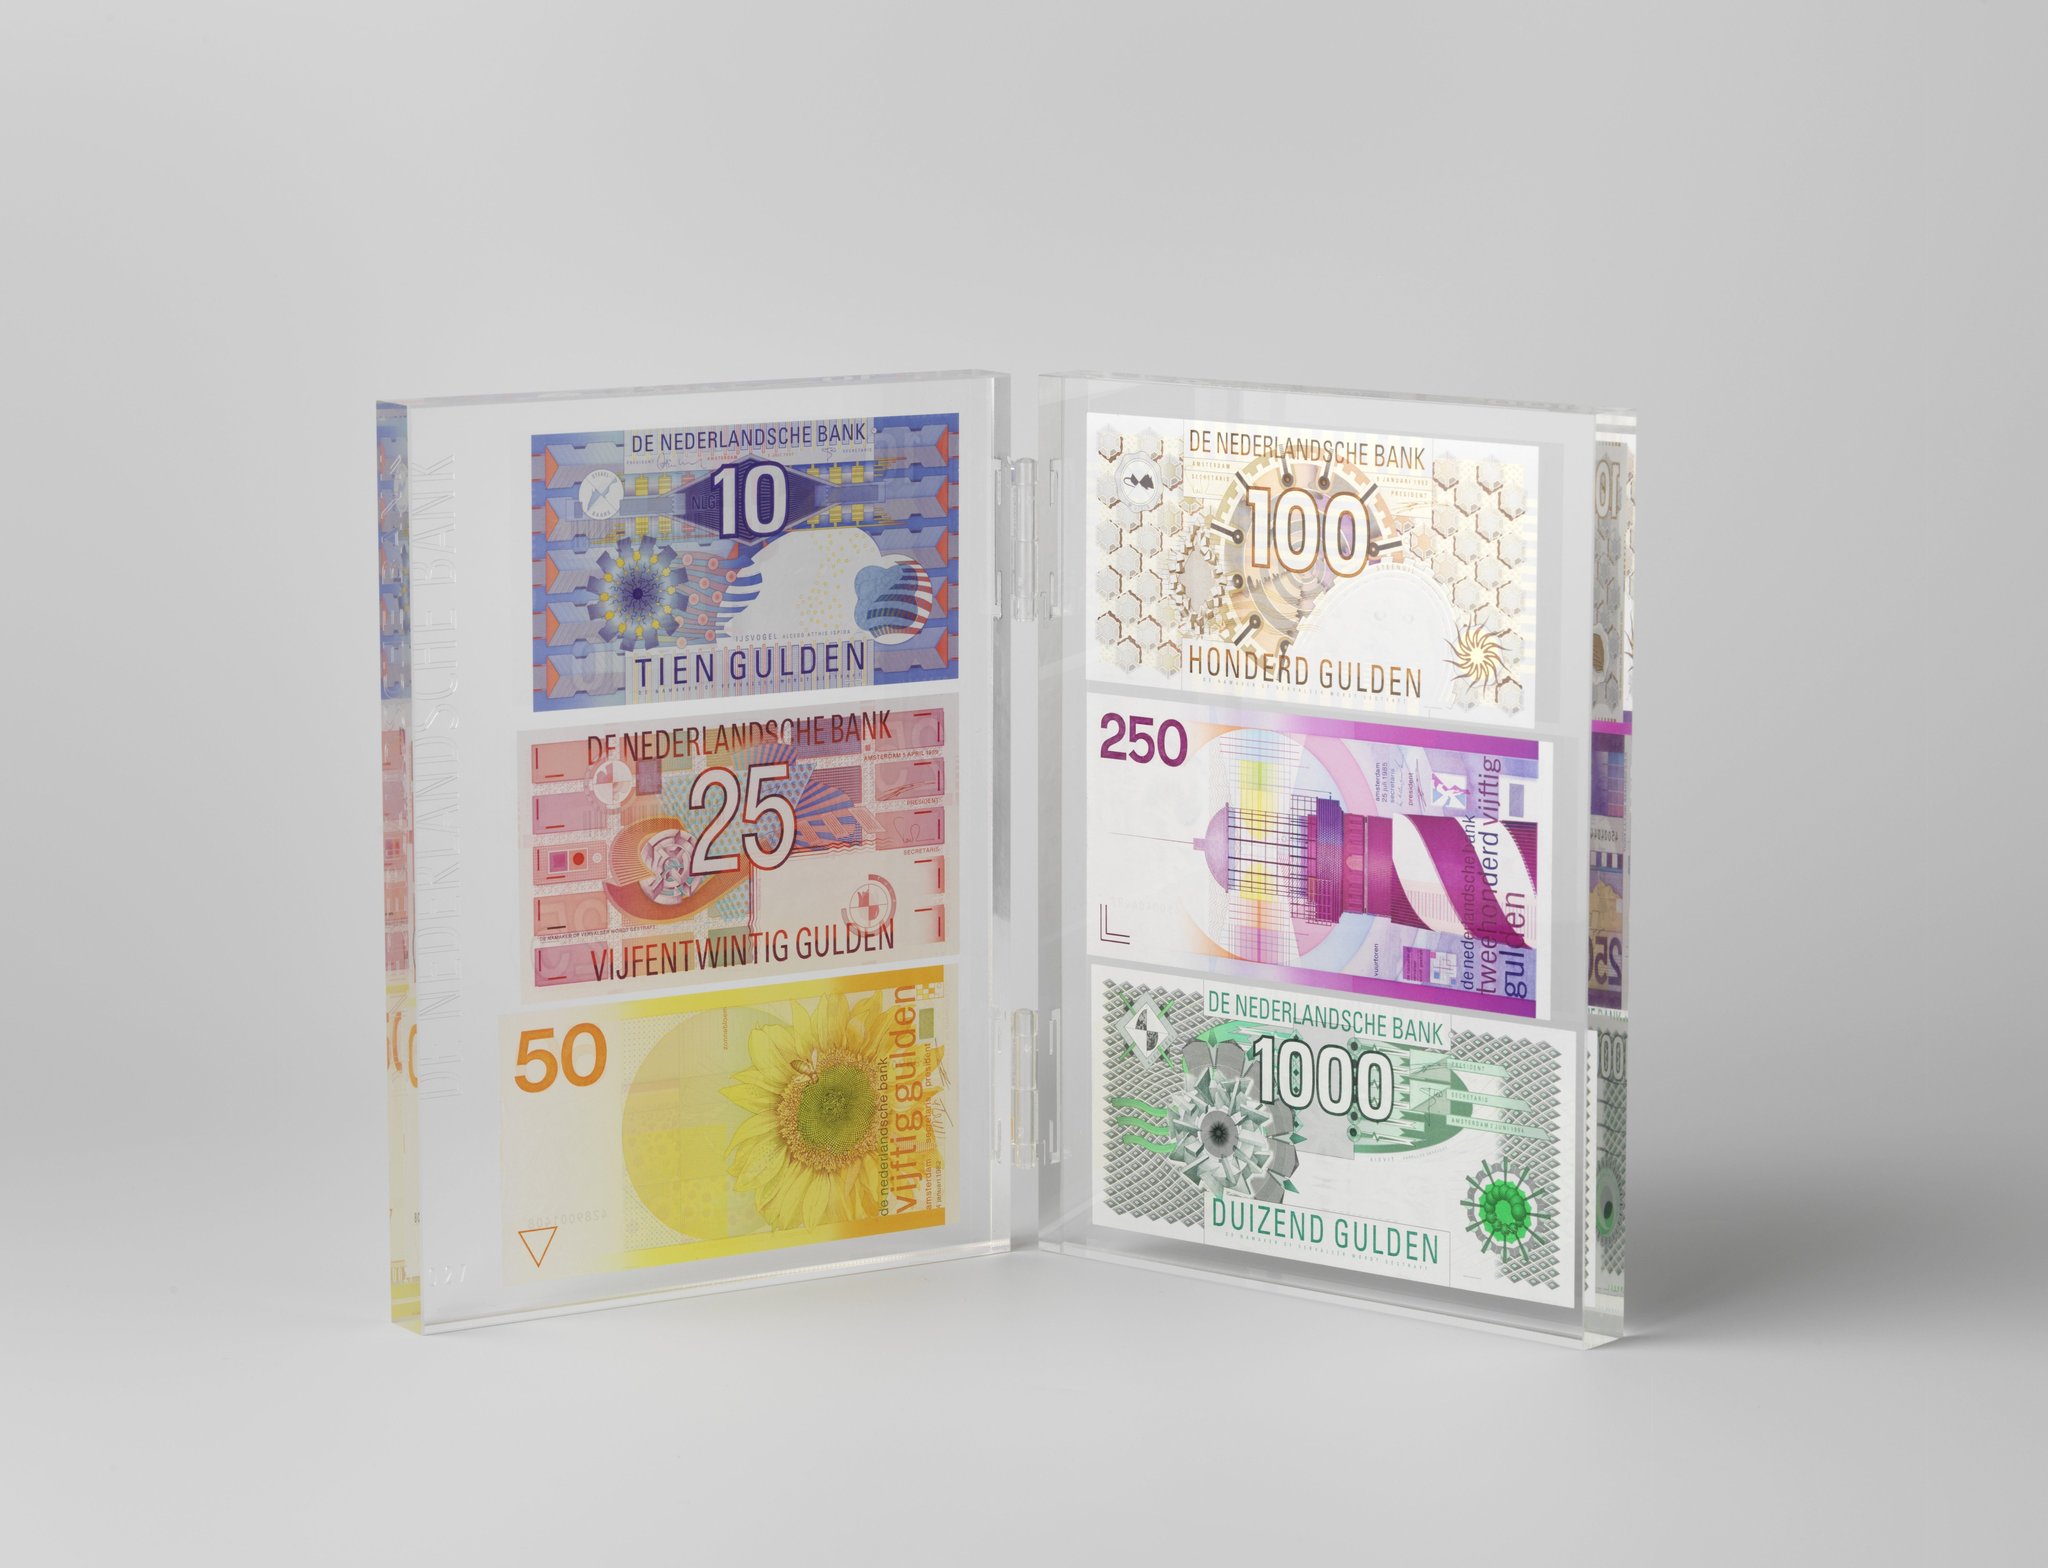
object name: bank note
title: Tweeluik van perspex met Nederlandse bankbiljetten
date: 1980-2001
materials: paper, plastic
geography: haarlem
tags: netherlands, europe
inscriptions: number: ‘0027’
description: Dit blok is uitgedeeld aan alle medewerkers van De Nederlandsche Bank en de gepensioneerden. Inn totaal zijn er 3100 vervaardigd.